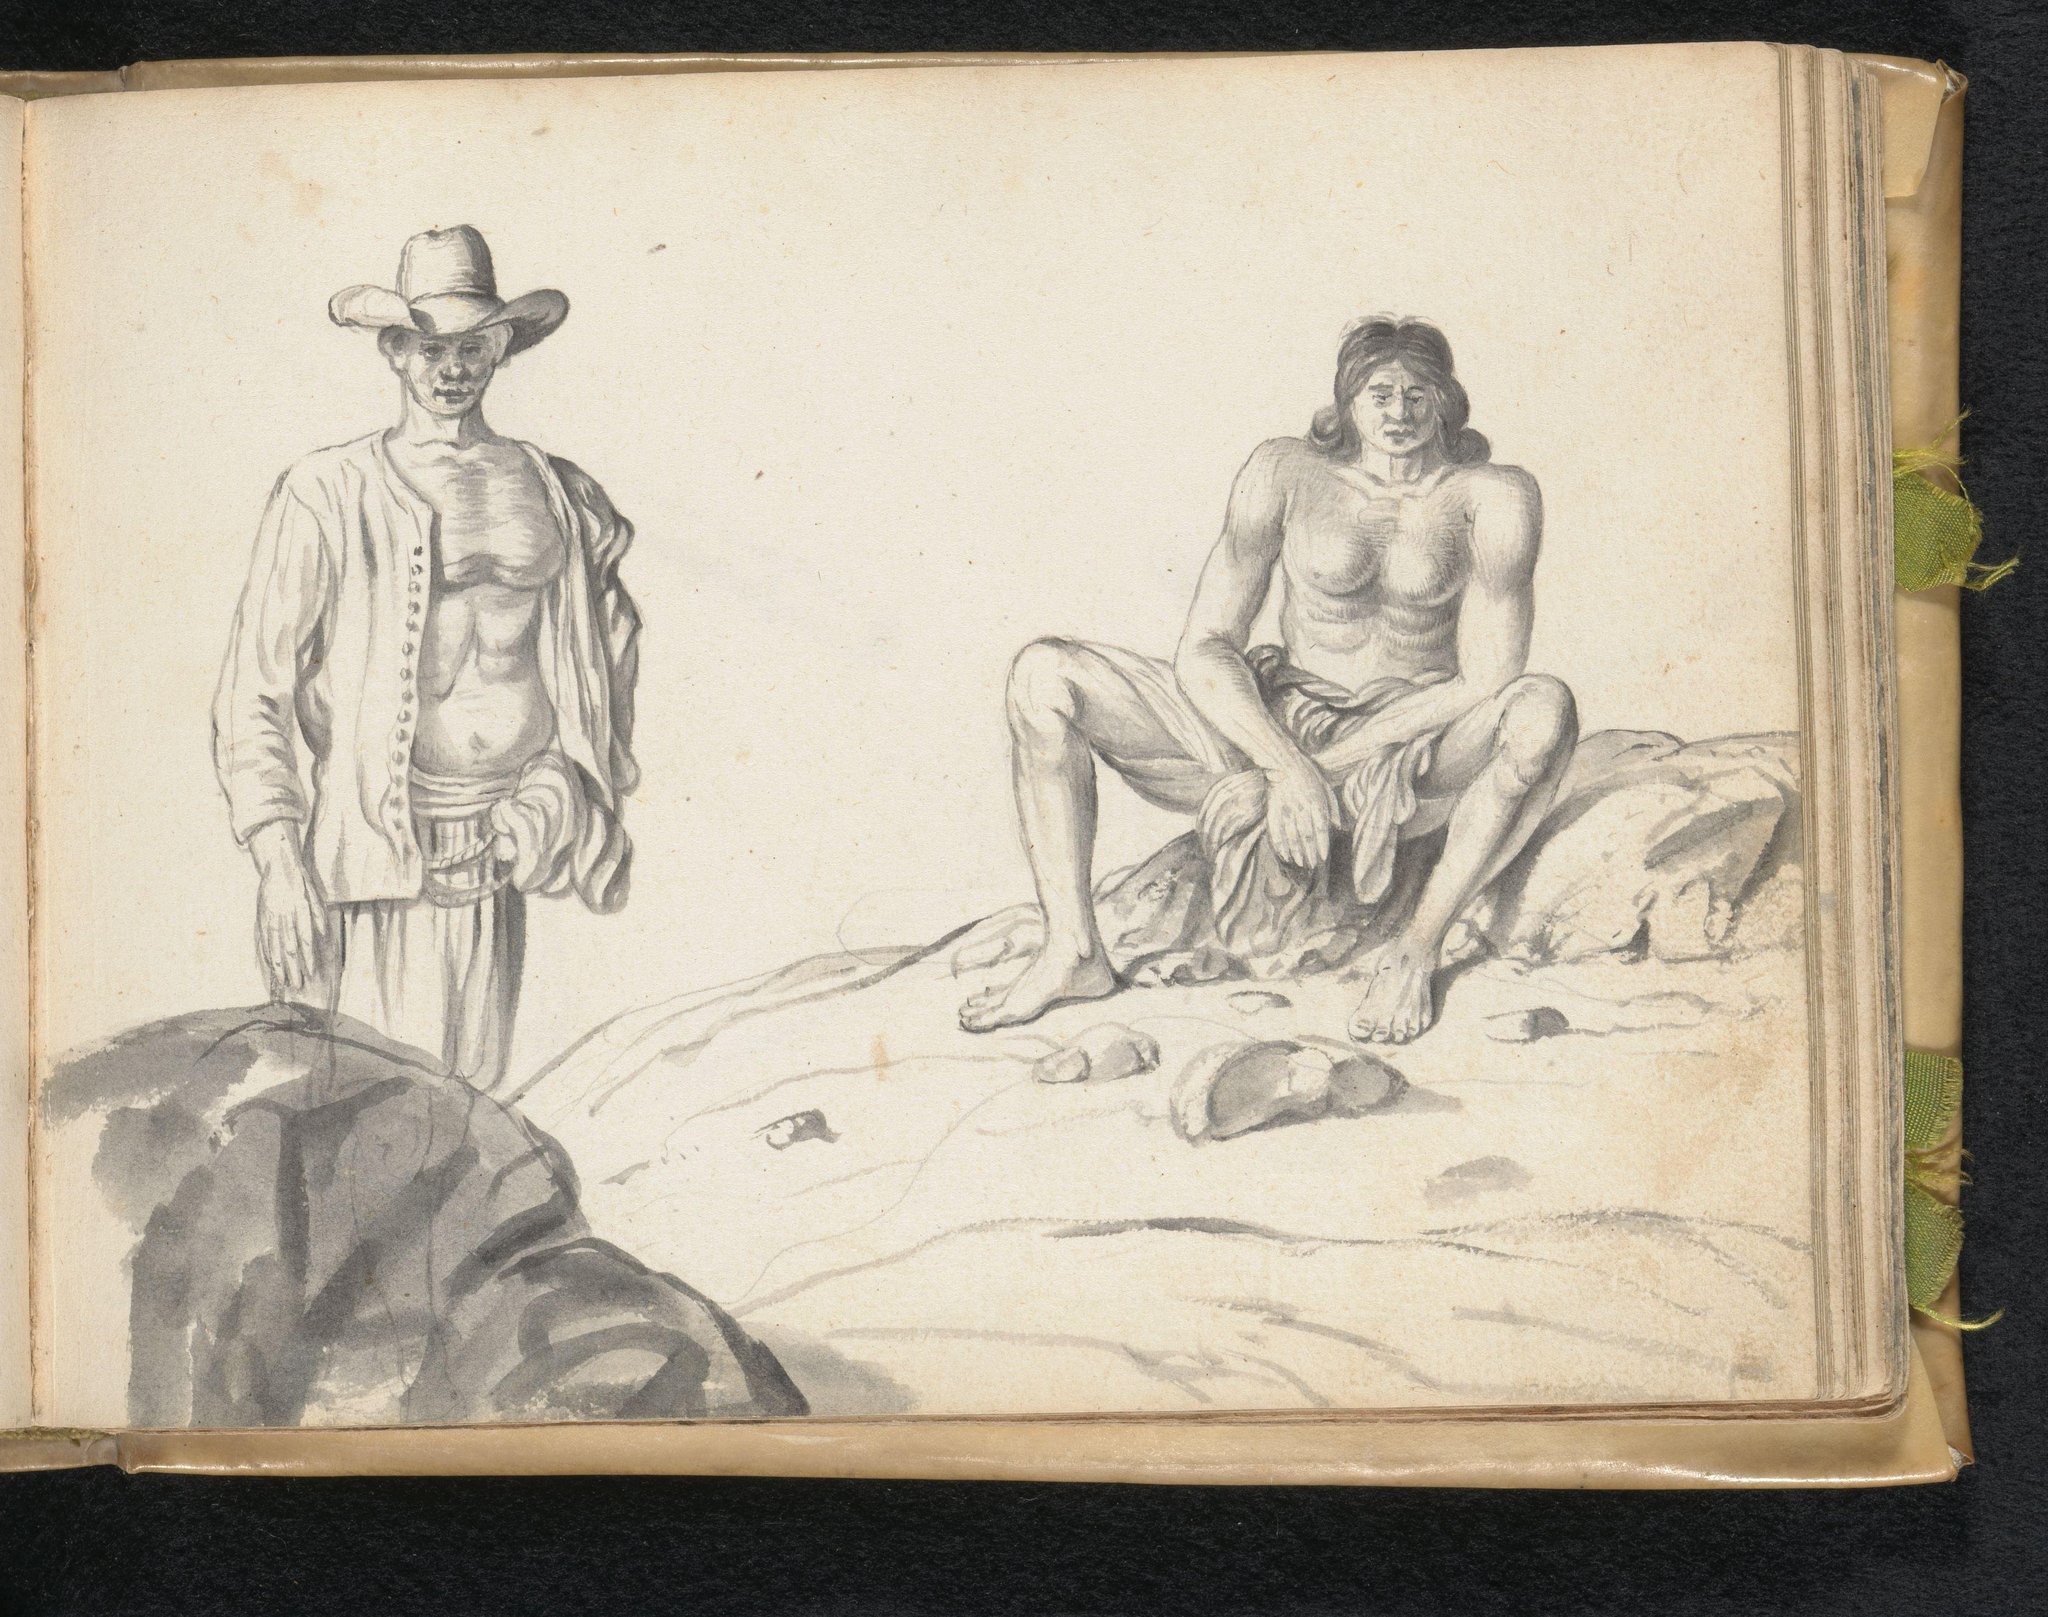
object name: sketchbook leaf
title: Two labourers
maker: esaias boursse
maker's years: 1631-1672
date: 1662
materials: ink, paper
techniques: brush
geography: sri lanka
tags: 41d232(...) skirt (lungi), head-gear (with name), clothing for the upper part of the body (with name), working class, labourers, asiatic races and peoples: indians, sri lanka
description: Links op een oneffen terrein vol losse stenen staat een man. Hij draagt een heupkleed (veshti, lungi) in de taille opgerold en vastgestoken. Daaronder zijn twee koorden getekend, waarschijnlijk vastgehouden door zijn linkerhand die schuilgaat onder een flap van zijn heupkleed. Om zijn gespierde bovenlijf draagt hij een wijd openhangend lang hemd (kamisaya) met lange mouwen en een knoopsluiting. Op zijn hoofd een breedgerande hoed (toppiya), mogelijk van vilt. Deze mix van Europese en Zuid-Indiase kleding duidt er op dat deze man een Toepas is, waarschijnlijk uit Jaffna. De man rechts zit met wijd gespreide blote benen en opgetrokken knieën op een rotsige helling. Hij gaat gekleed in een hoog opgeschort heupkleed (veshti, lungi). Zijn bovenlijf en armen zijn onbedekt. Hij kan afkomstig zijn uit Zuid-India, Jaffna of Colombo. Blad 75 uit een schetsboek met 117 bladen.